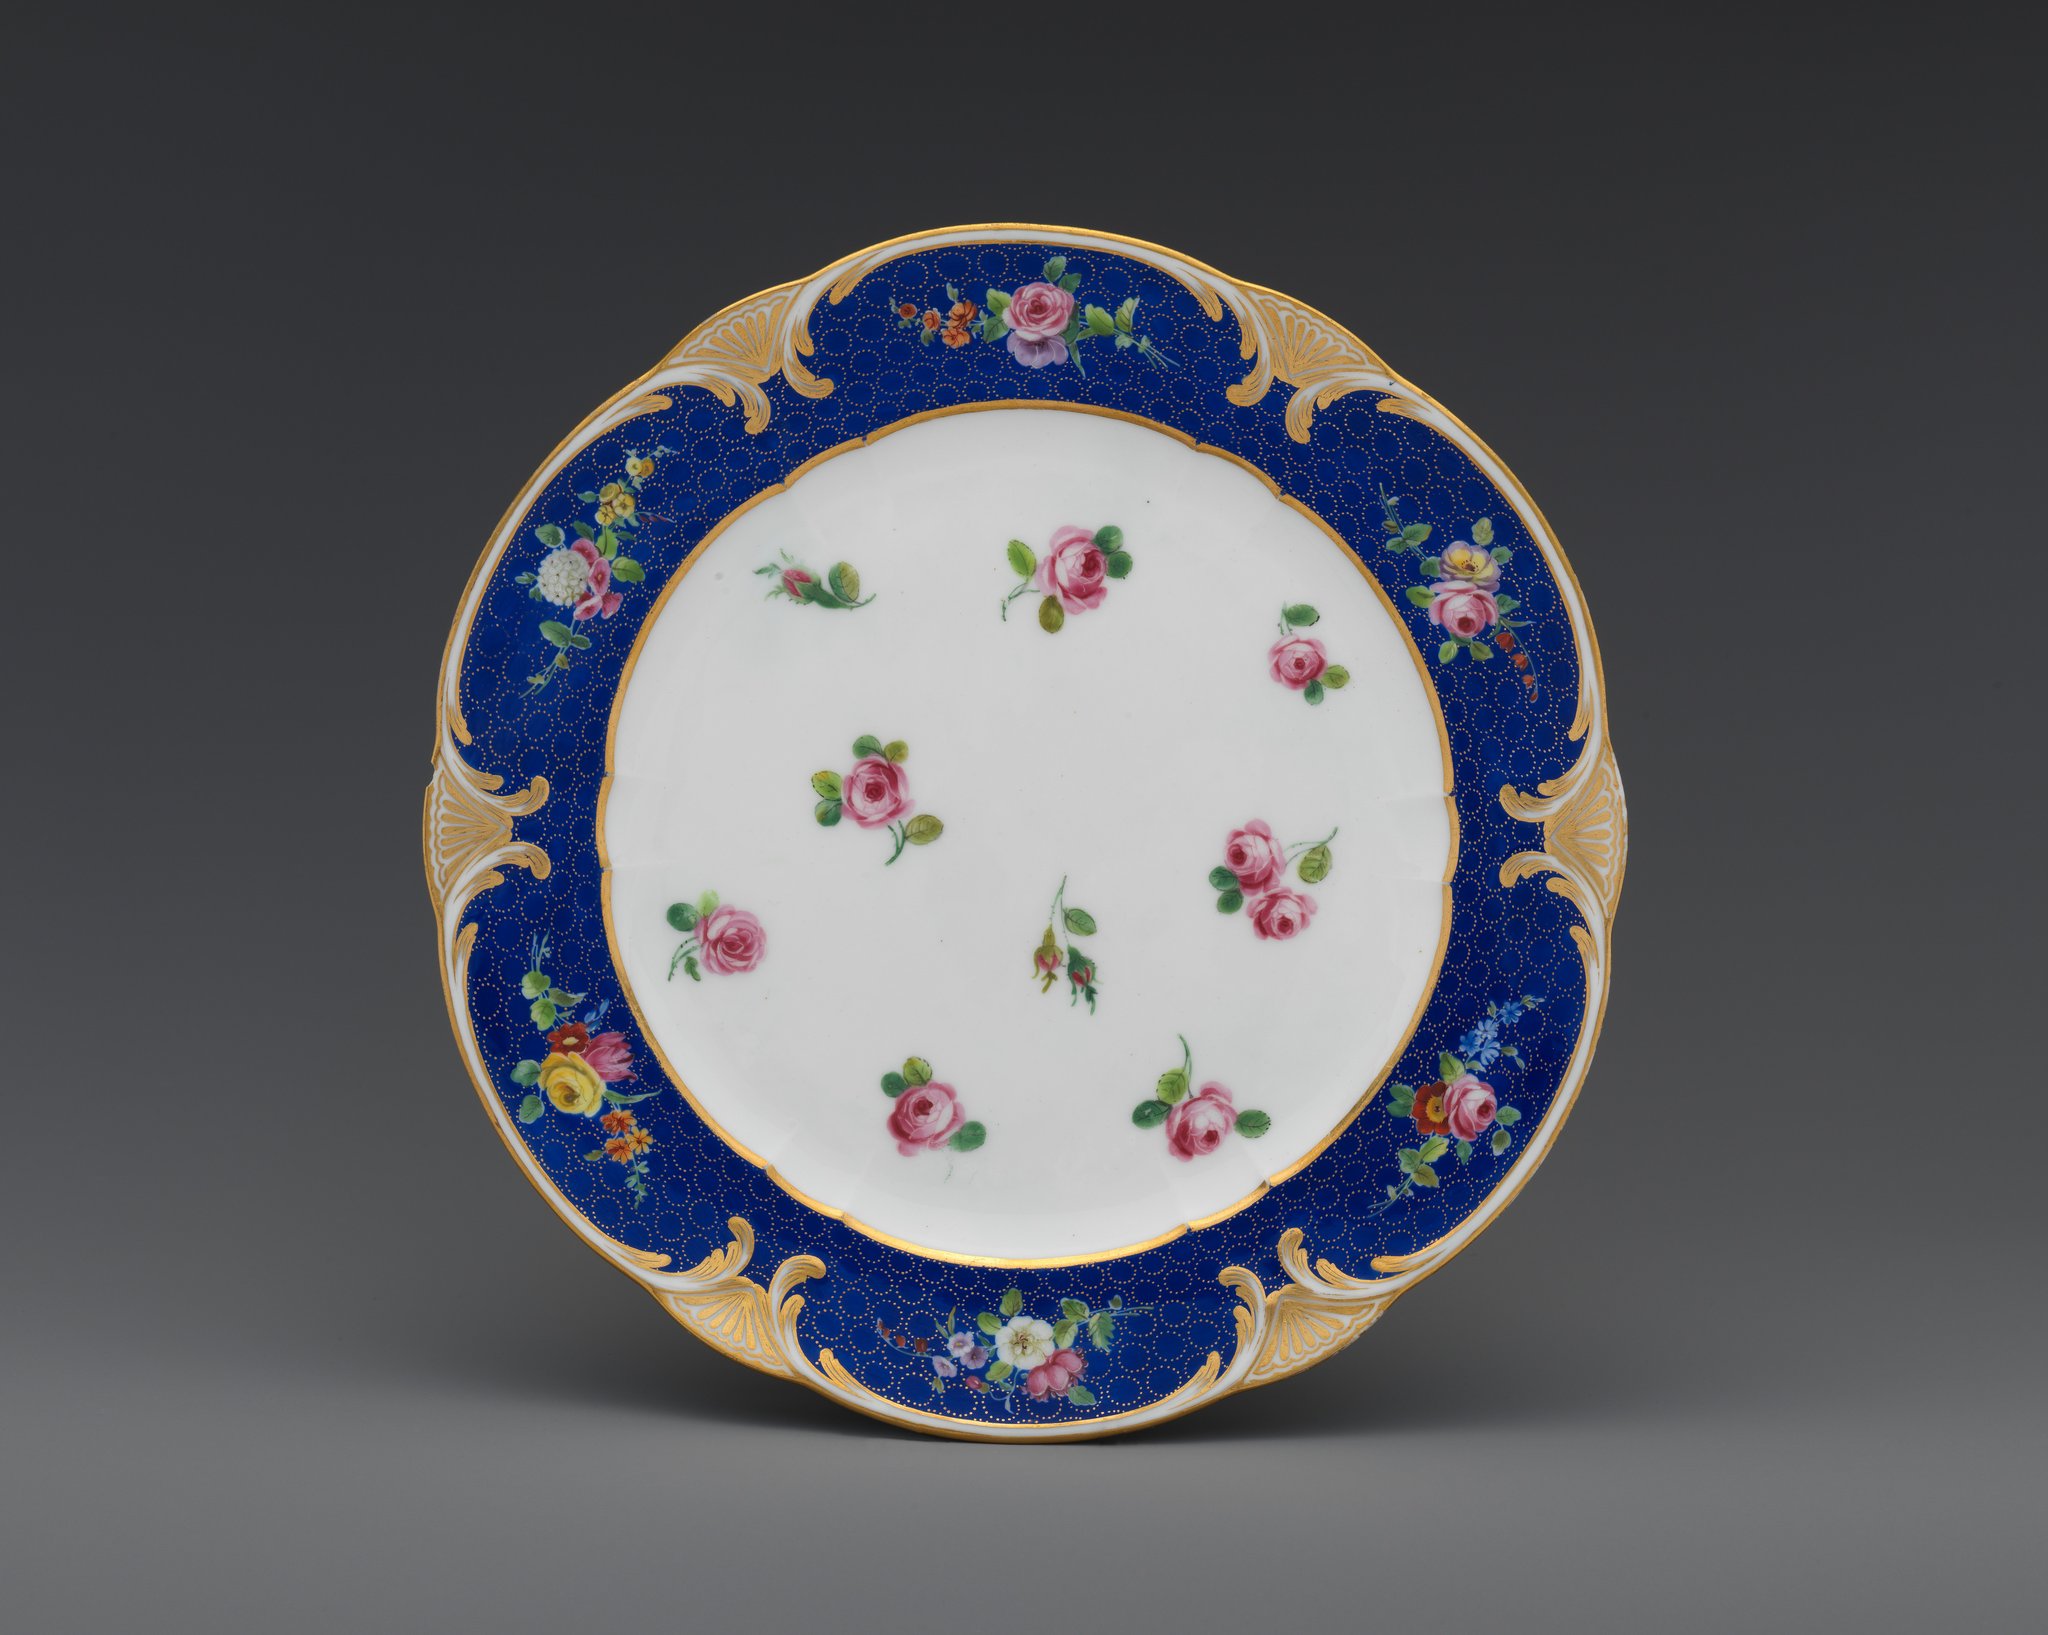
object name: plate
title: Plate (assiette à palmes)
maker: sèvres manufactory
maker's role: manufactory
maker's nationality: french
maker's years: 1740-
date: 1771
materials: soft paste porcelain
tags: roses